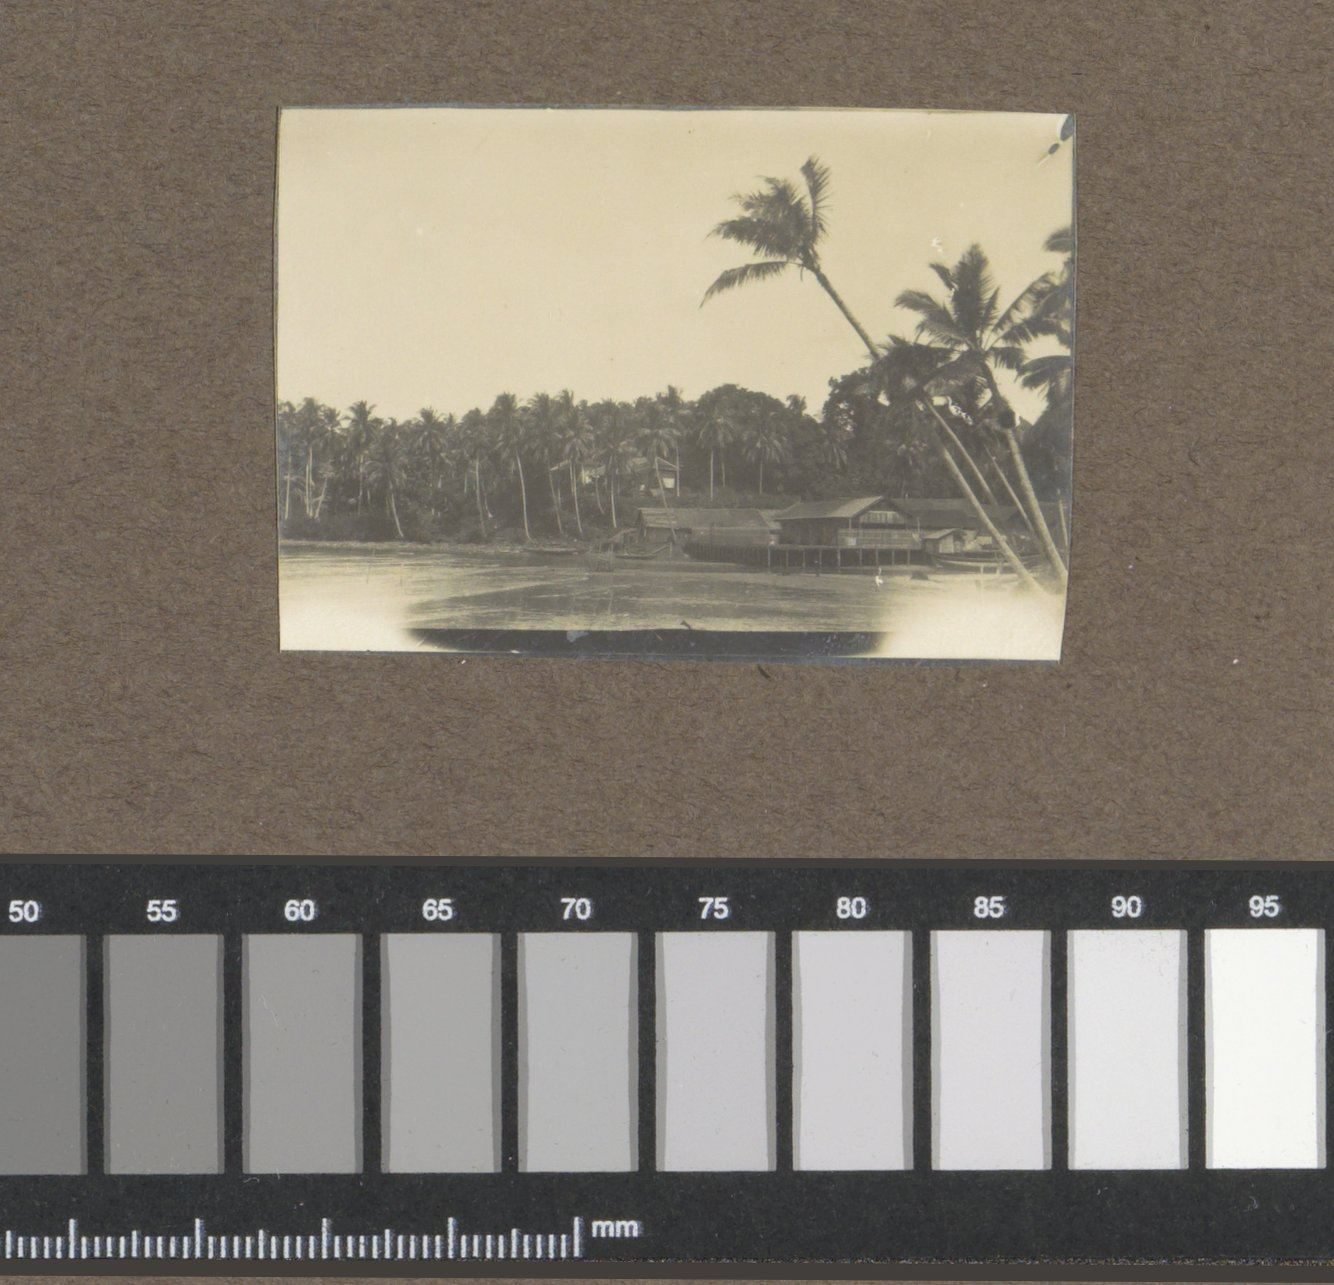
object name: photograph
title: Oever met gebouw op palen in Nederlands-Indië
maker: klaas kleiterp (i)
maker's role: arts, officier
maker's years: 1892-1943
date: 1920-1930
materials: paper, photographic support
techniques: gelatin silver print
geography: dutch east indies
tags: river bank, dutch east indies, the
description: Onderdeel van Fotoalbum van de familie Kleiterp-Vermeulen met opnames van Nederlands-Indië.